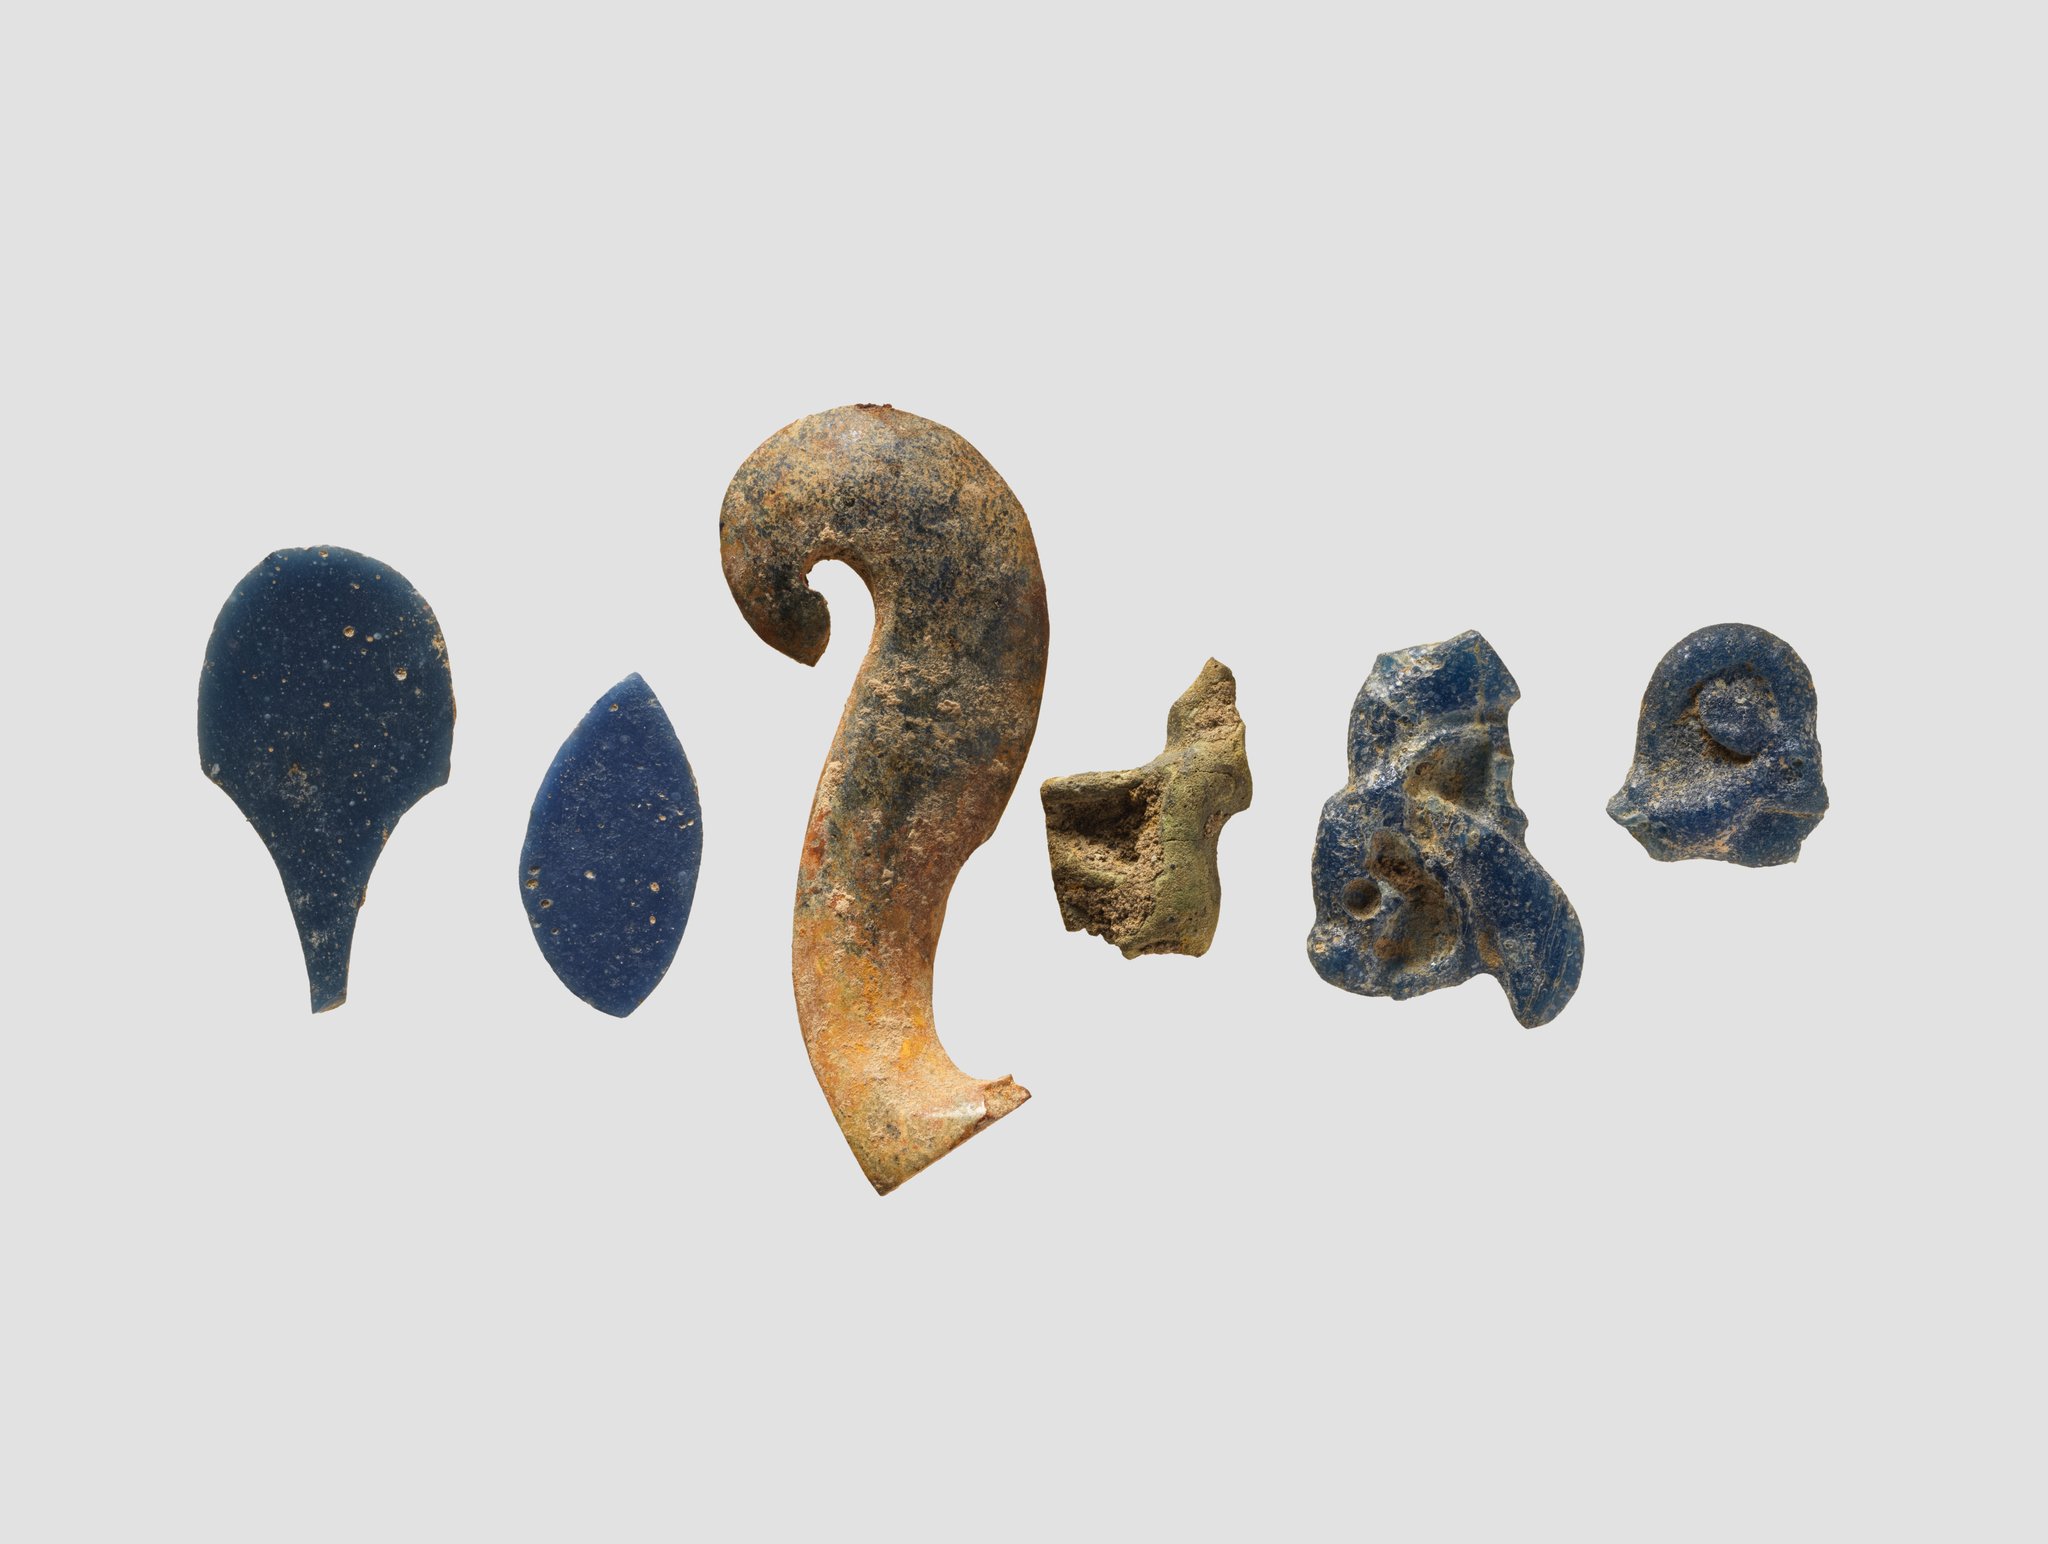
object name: inlay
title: Inlays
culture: assyrian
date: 800-601 BCE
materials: glass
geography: mesopotamia